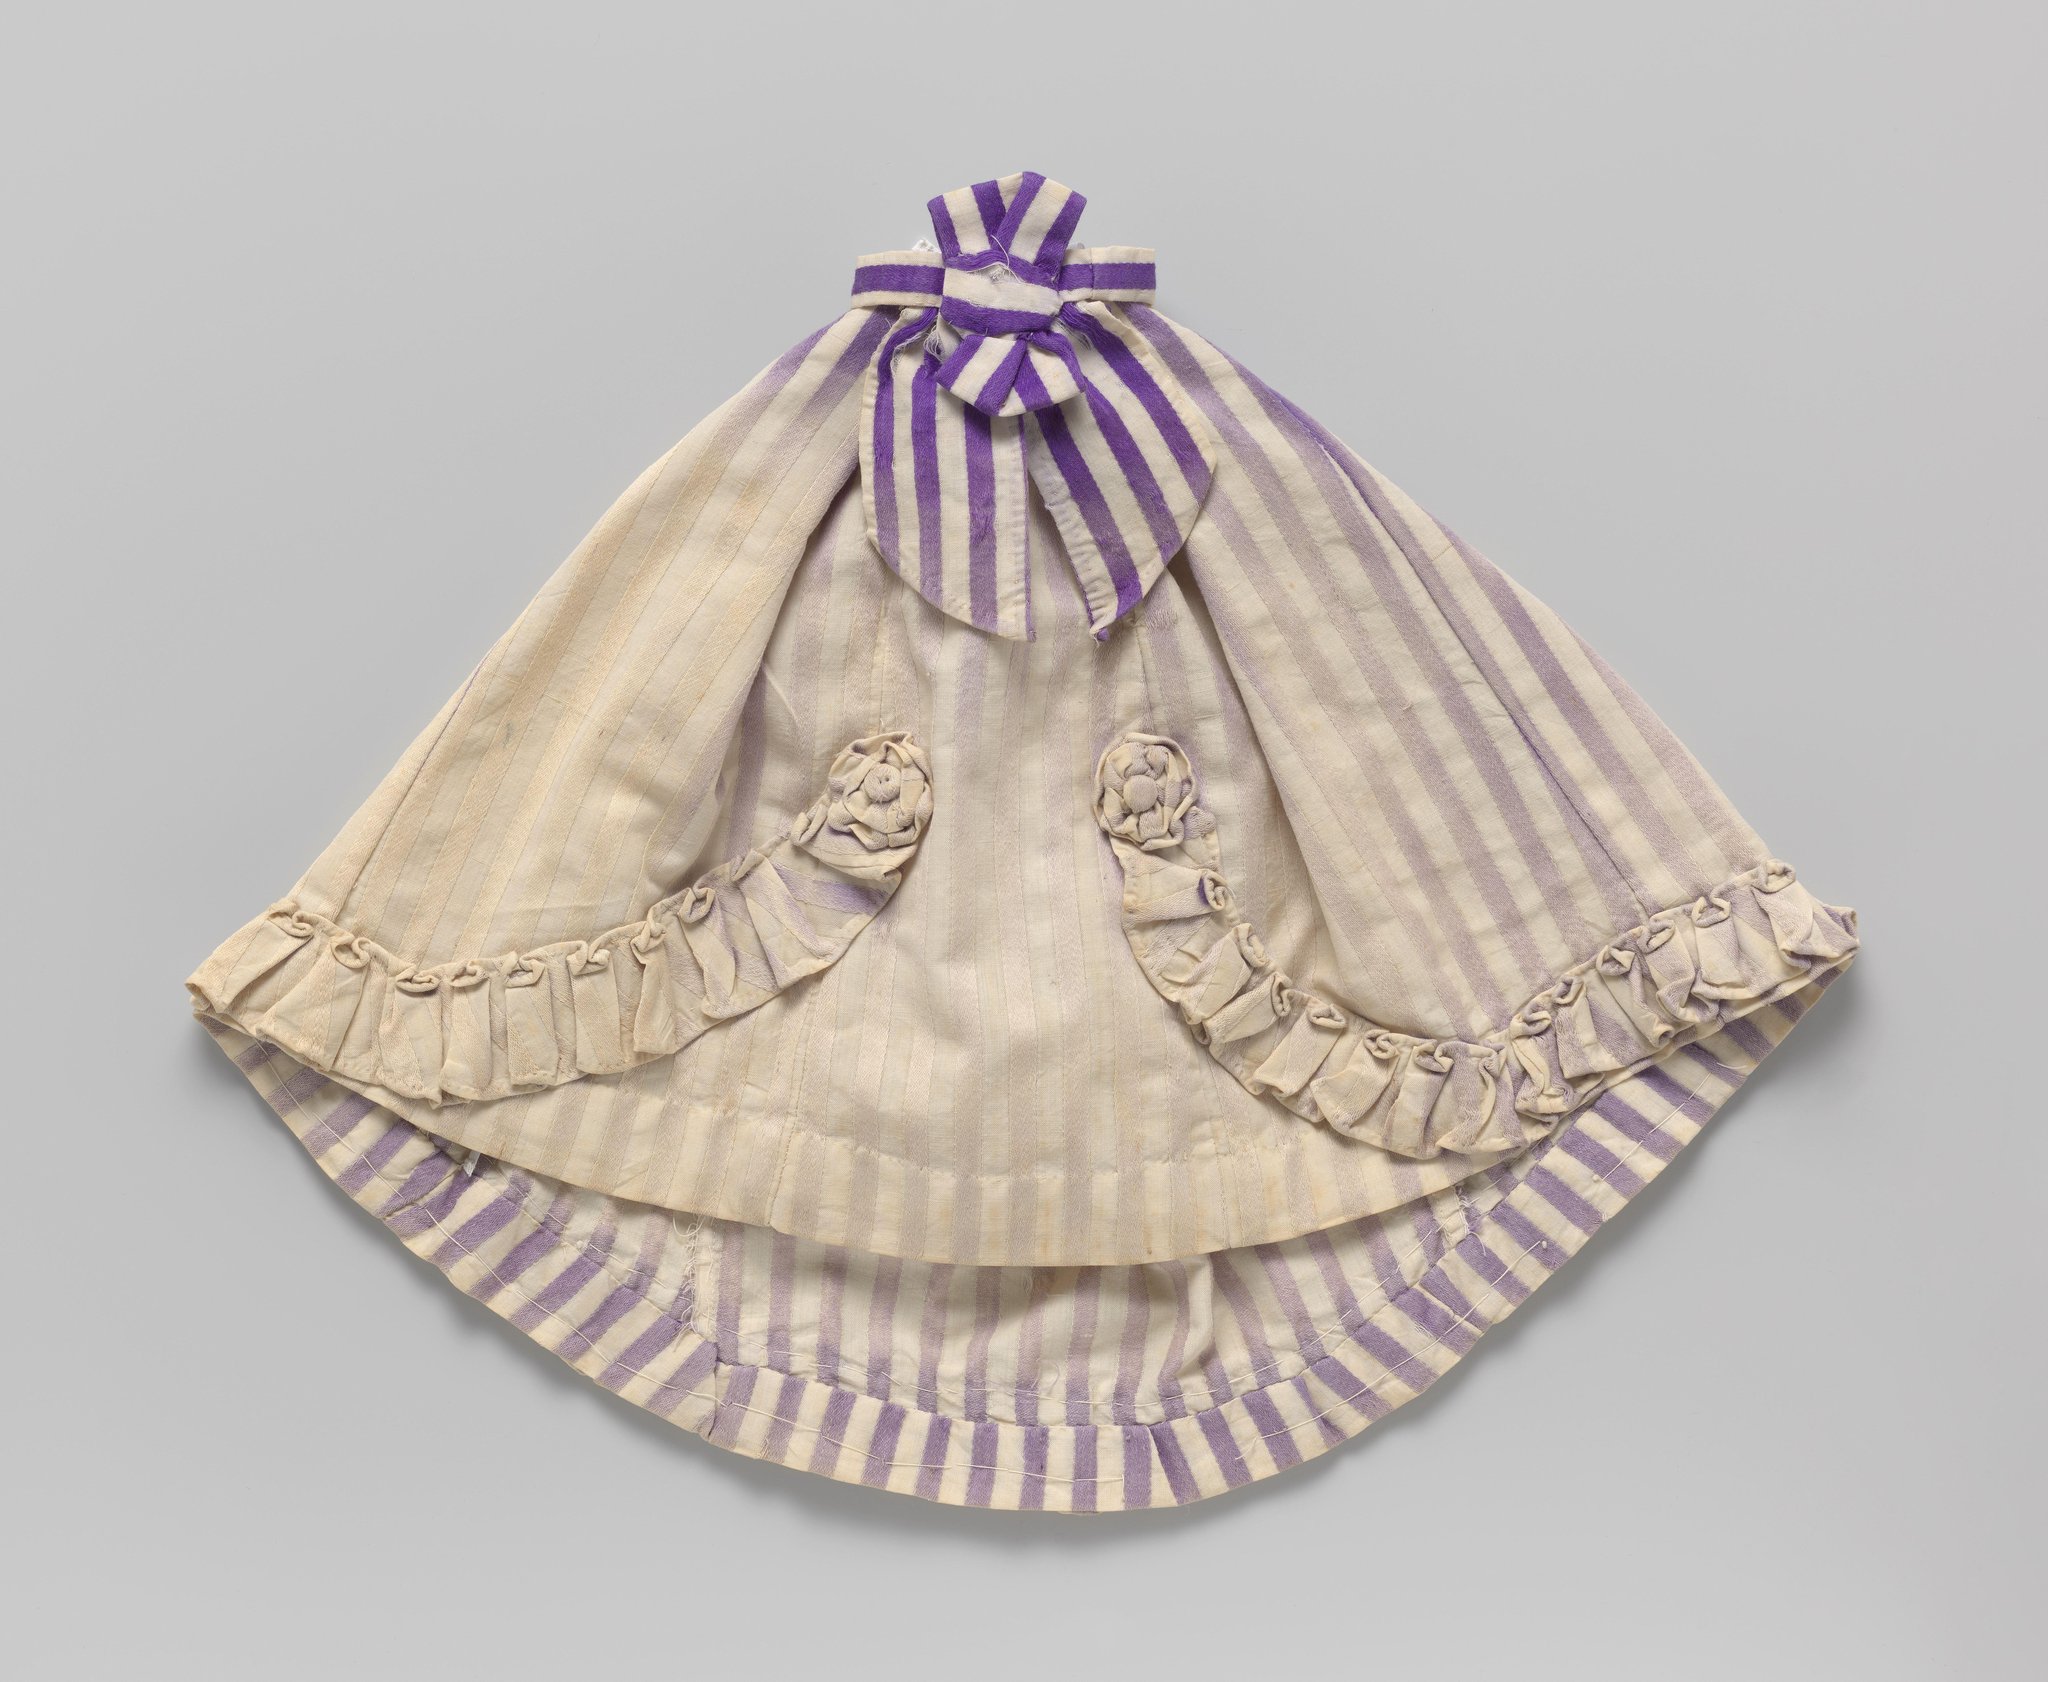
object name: doll's clothing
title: Rok met strepen van paars satijn.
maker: Anonymous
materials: cotton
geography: netherlands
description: Rok, witte katoen met strepen van paarse satijn; met gerimpelde strook.